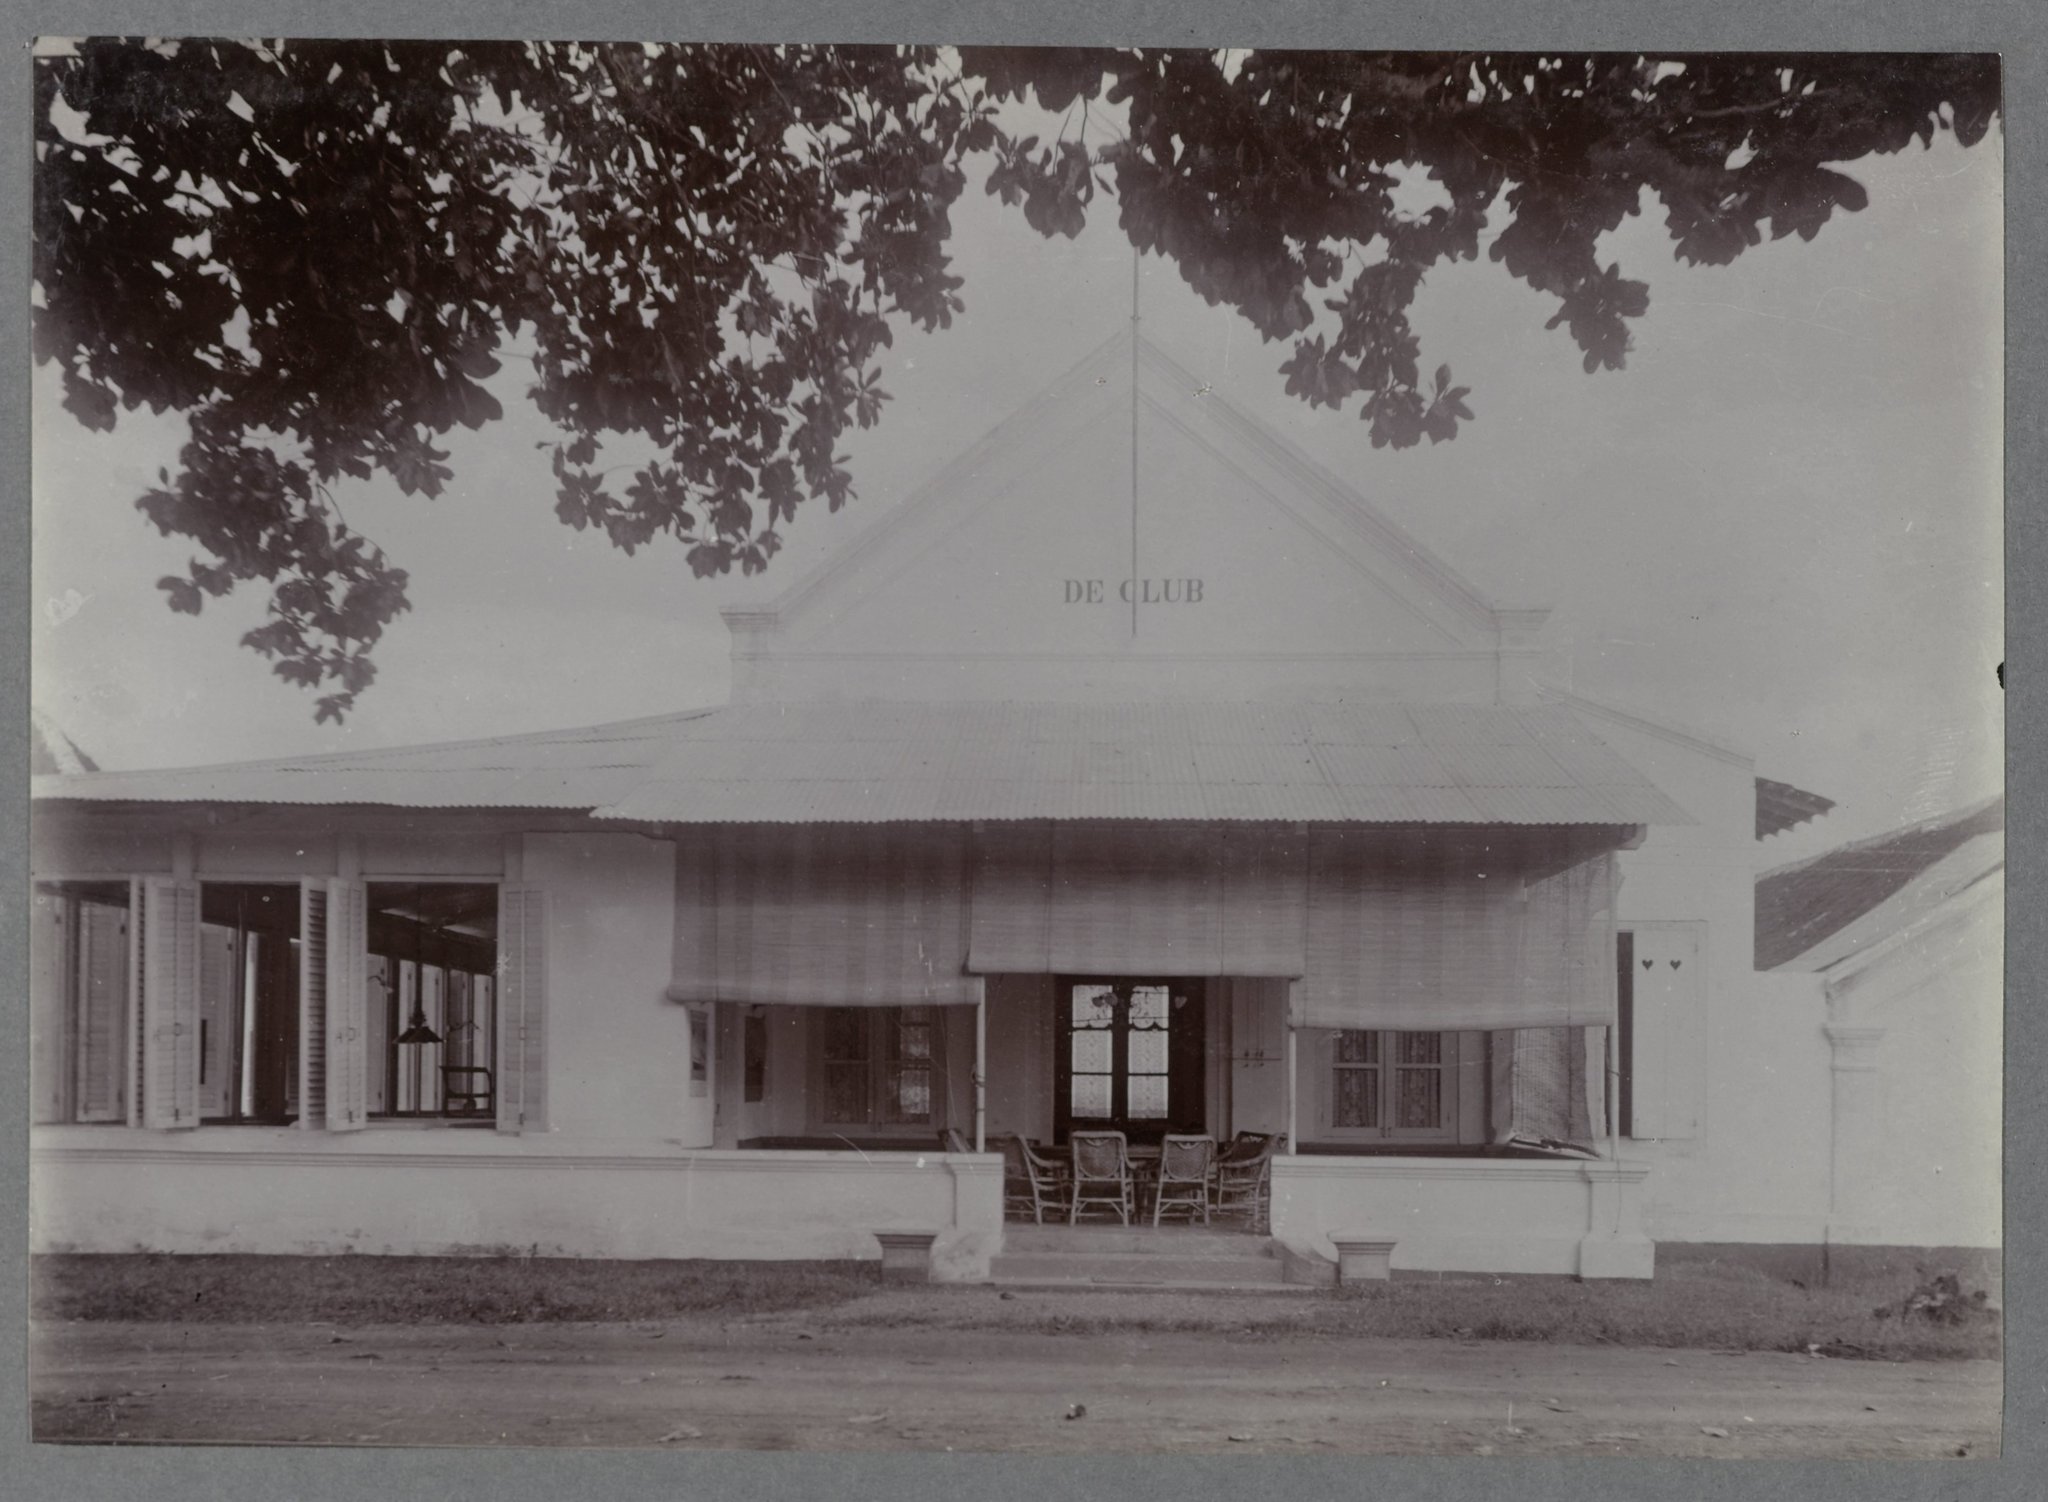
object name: photograph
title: De Club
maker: Anonymous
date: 1900-1919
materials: photographic support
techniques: collodion silver print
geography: comal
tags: colonial system, club, meeting place, (non-fruit) products of plants or trees: sugarcane, exterior of industrial structures, factories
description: Het gebouw van de club behorend bij de suikerfabriek. Onderdeel van het fotoalbum van de Tjomal suikerfabriek in de periode ca. 1900-1919.